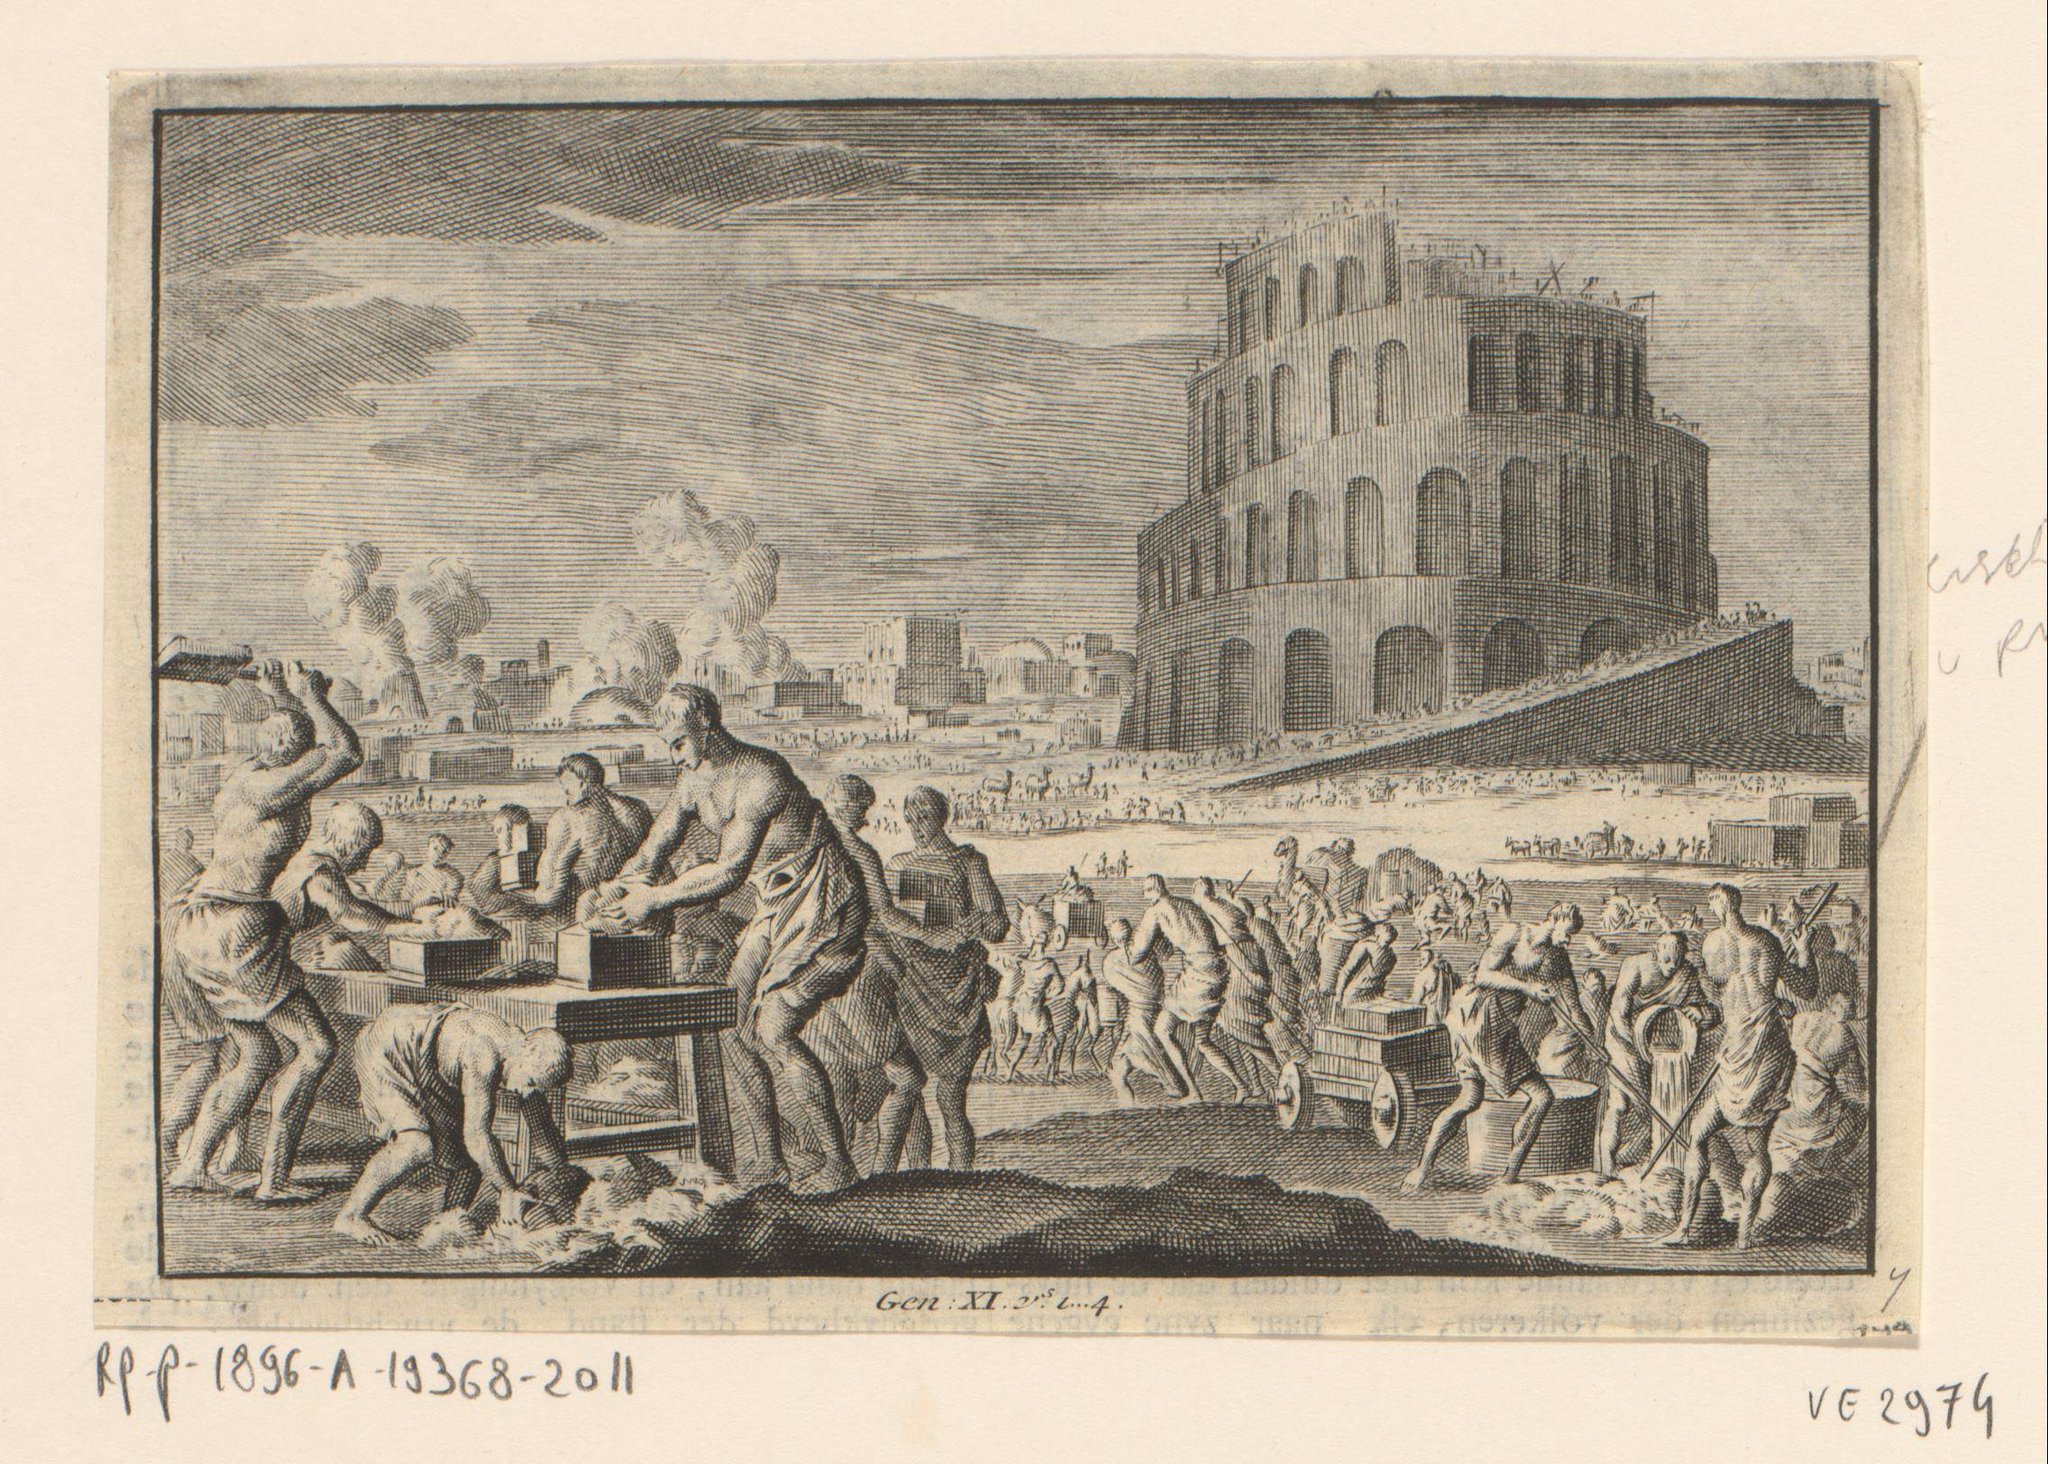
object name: book illustration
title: Bouw van de toren van Babel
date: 1703-1762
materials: paper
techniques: etching, letterpress printing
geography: amsterdam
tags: the building of the tower of babel; nimrod may be present, supervising or assisting the construction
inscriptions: collector's mark: Lugt 2228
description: De prent komt een eerste keer voor als boekillustratie voor David Martin. Historie des Ouden en Nieuwen Testaments. Amsterdam, Pieter Mortier, 1703. Deel I. De boekillustraties voor de Mortierbijbel hebben verschillende staten en kopieën, waarbij de chronologische volgorde moeilijk te achterhalen valt. Als boekillustraties werden ze bovendien herhaaldelijk opnieuw gebruikt voor andere boekwerken.